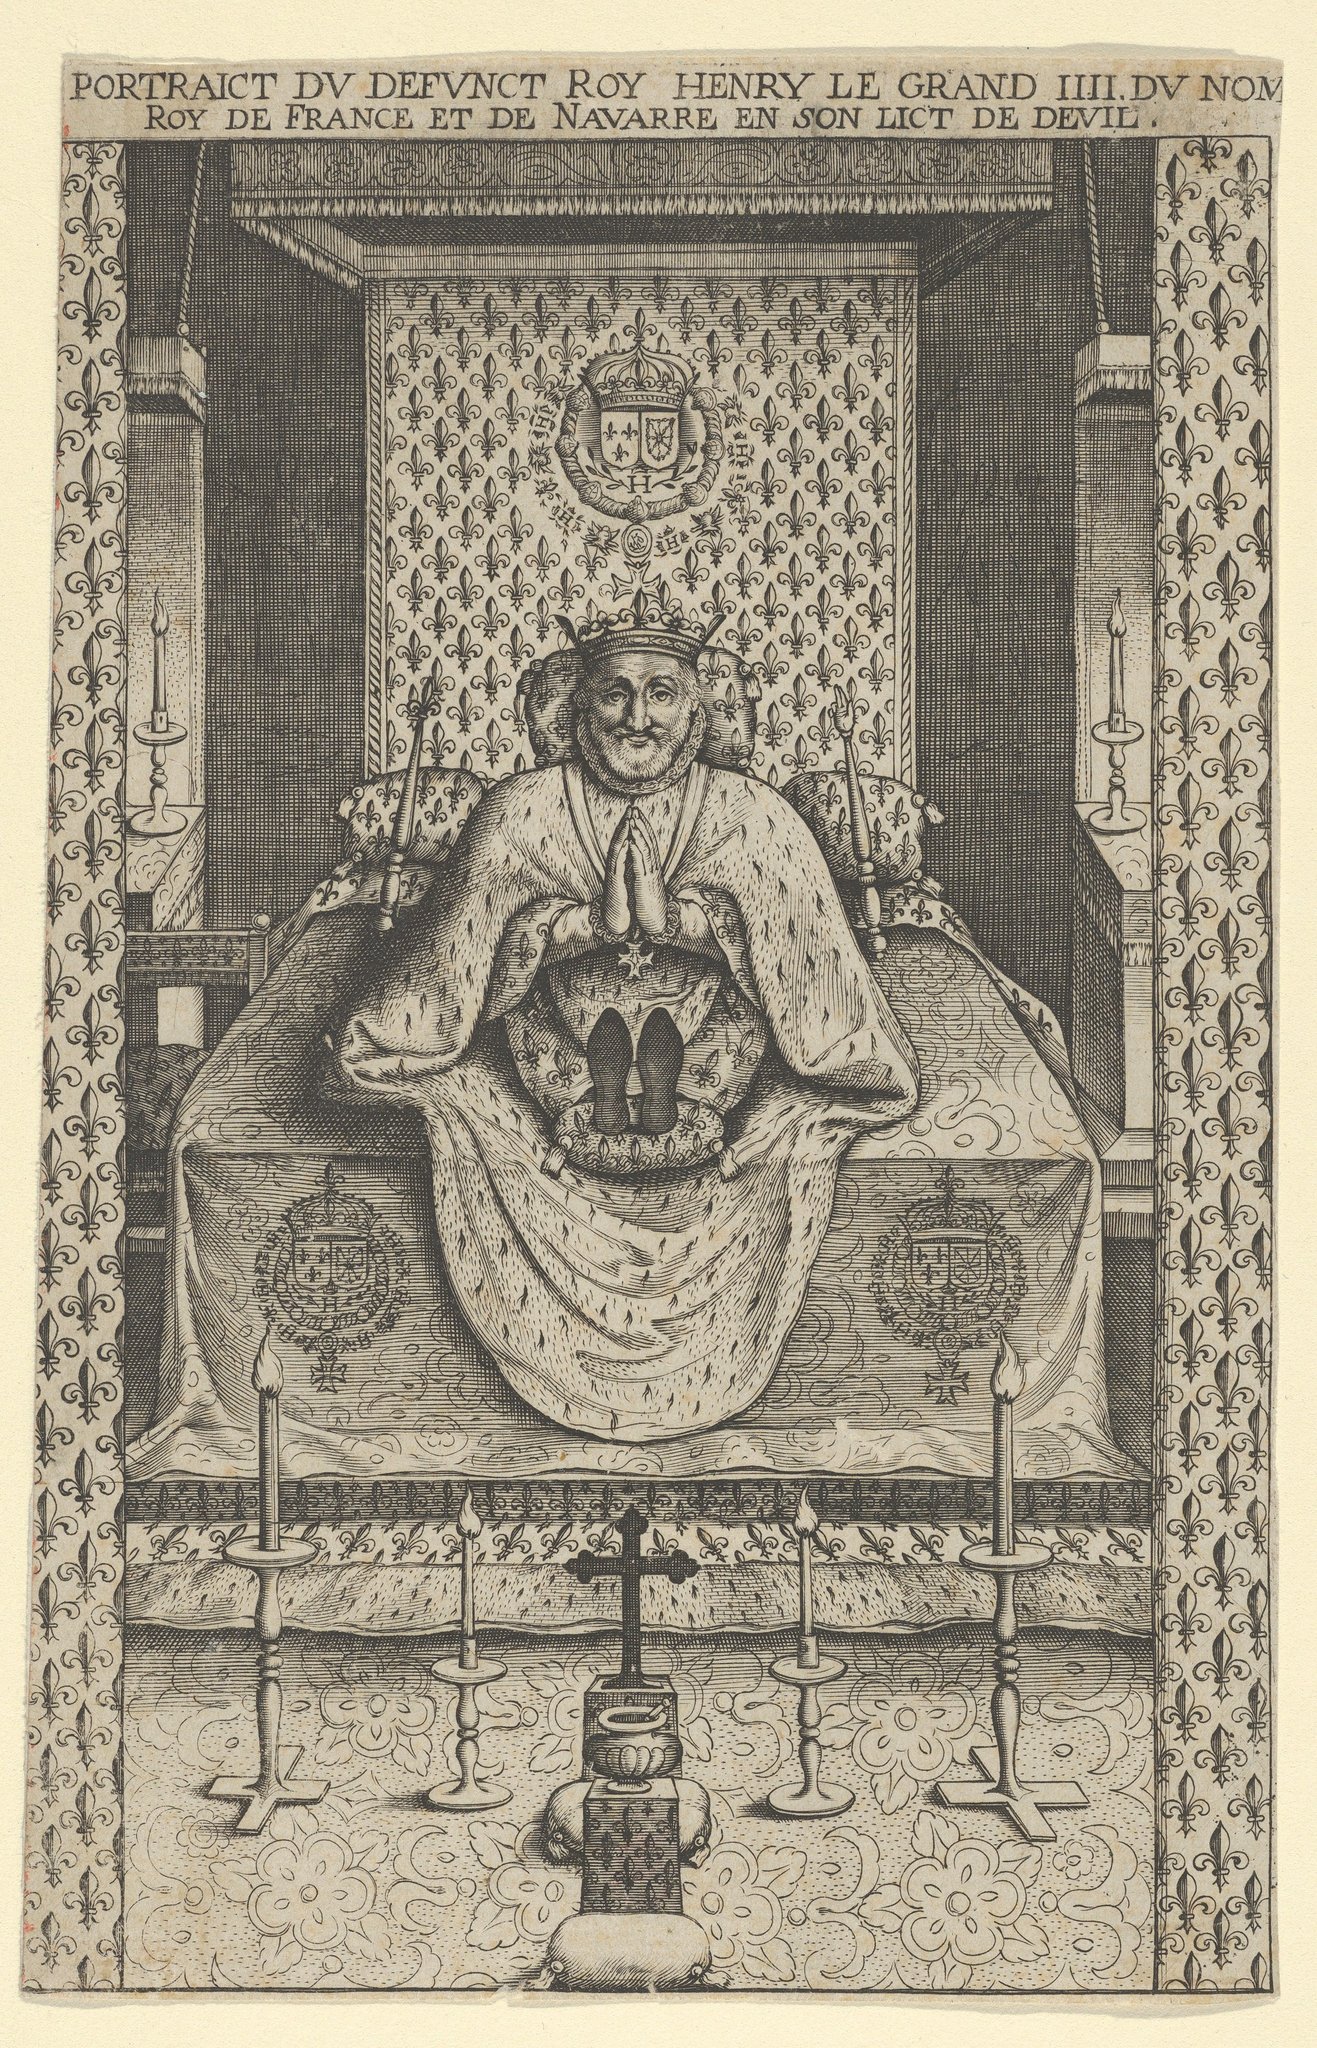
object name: print, fete, ornament architecture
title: Funeral effigy of Henry IV, King of France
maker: anonymous, french, 17th century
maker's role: artist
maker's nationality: french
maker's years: 1600-1700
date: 1610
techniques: etching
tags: kings,coat of arms